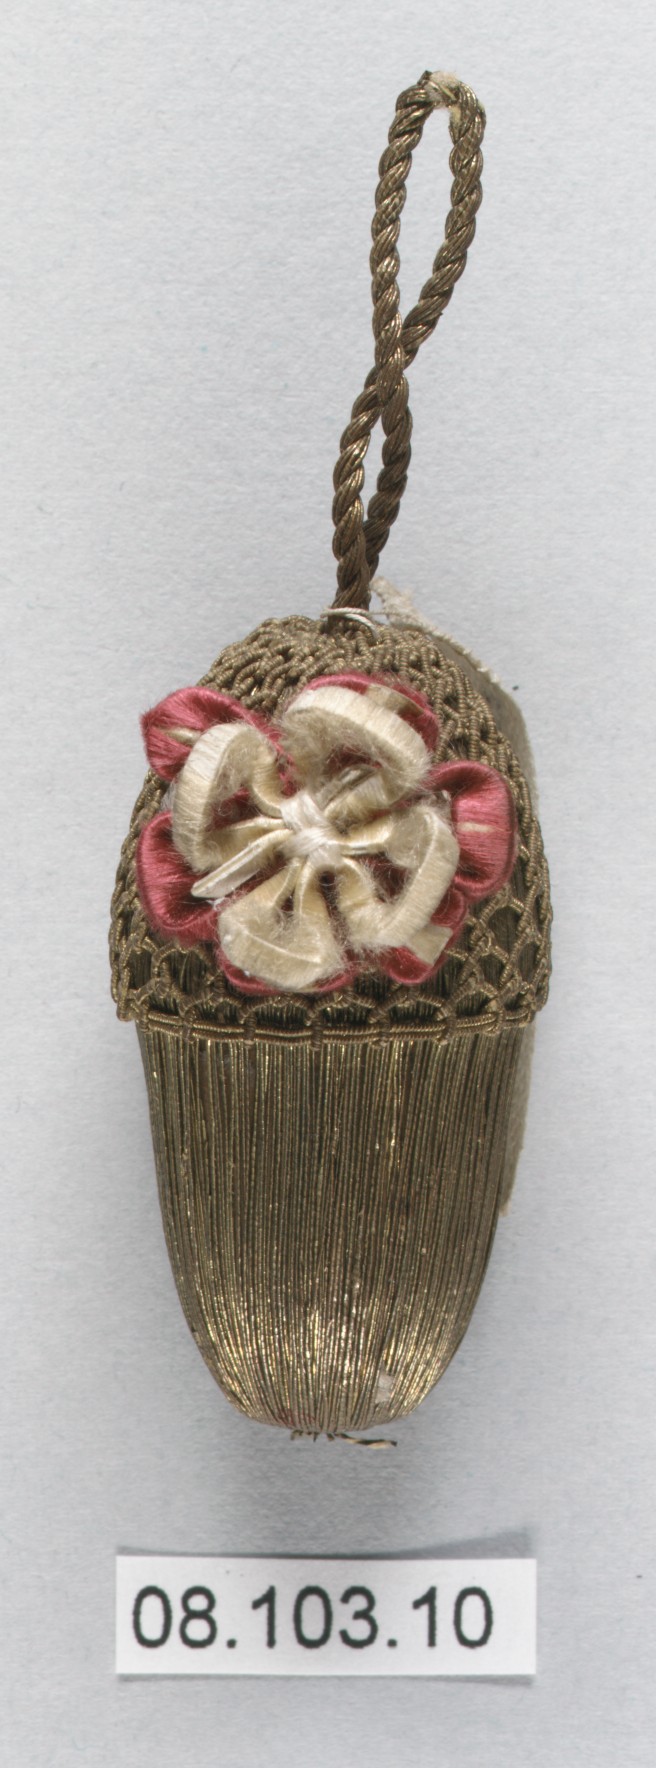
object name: tassel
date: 1701-1800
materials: silk